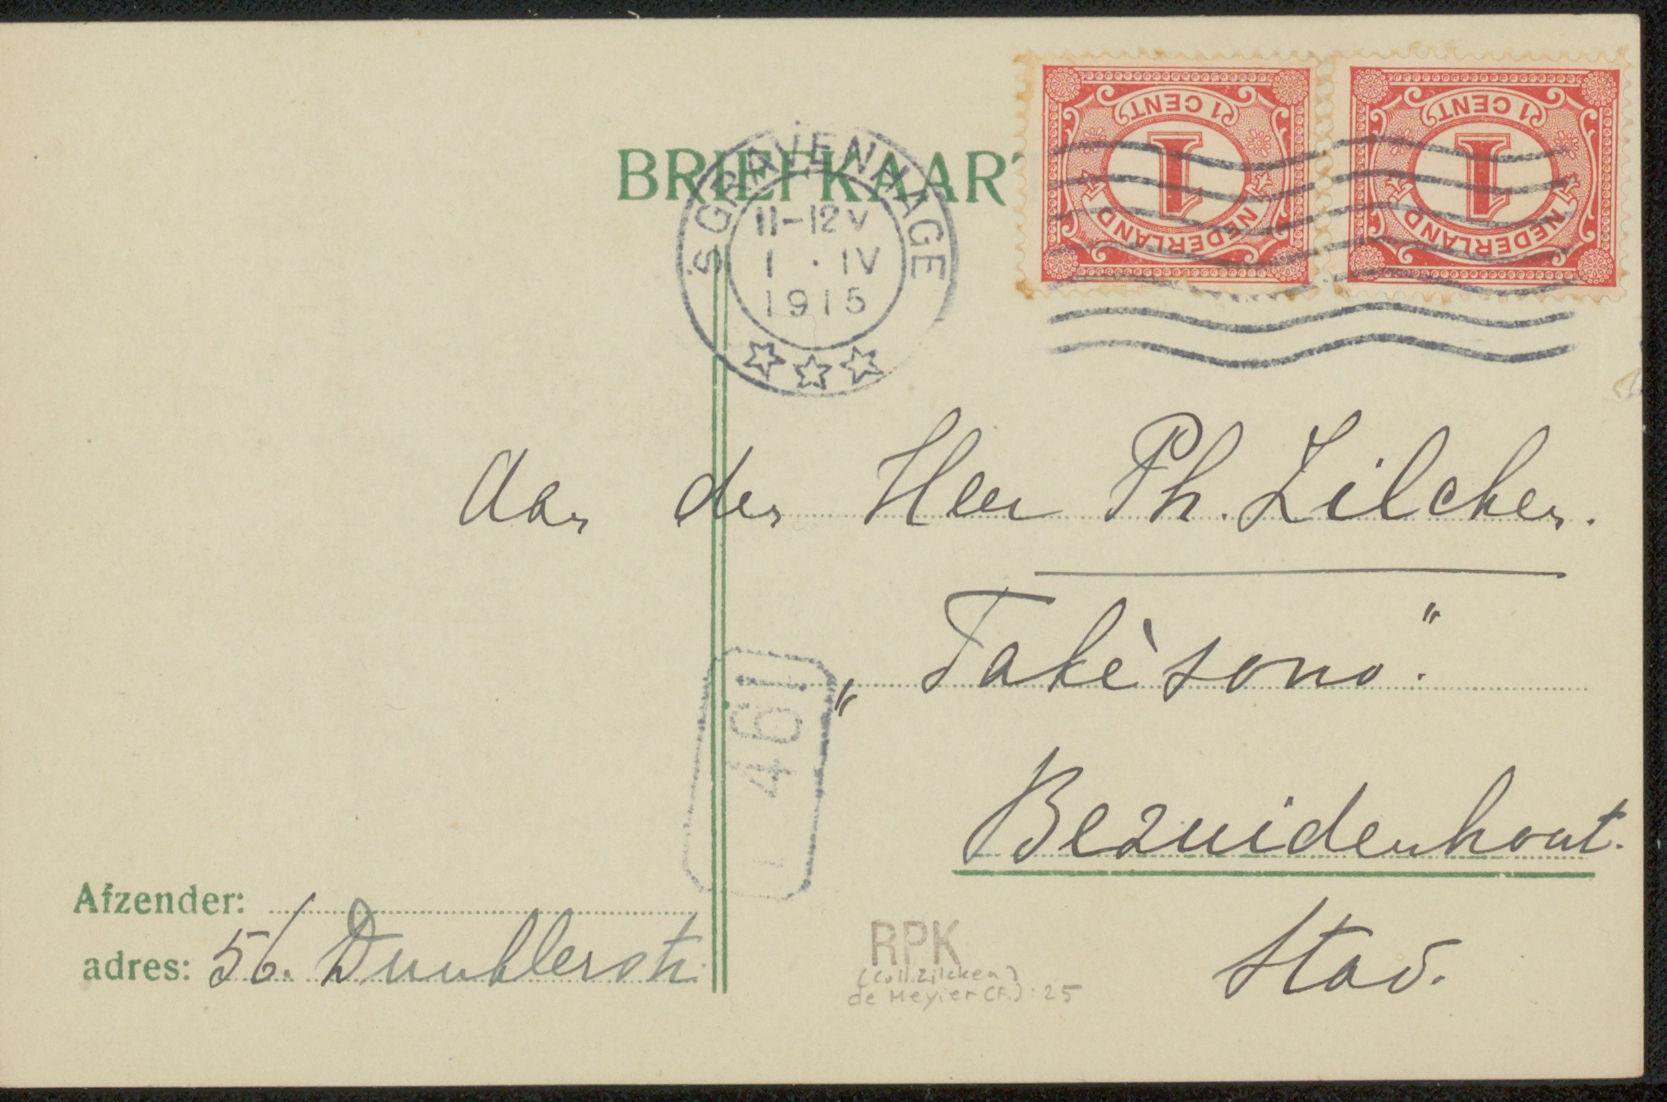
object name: postcard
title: Briefkaart aan Philip Zilcken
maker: fenna de meyier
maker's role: onderwijzer, schrijver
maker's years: 1874-1943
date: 1915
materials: cardboard, ink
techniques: pen, writing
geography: the hague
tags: painter, draughtsman, philip zilcken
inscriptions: collector's mark: ‘RPK’